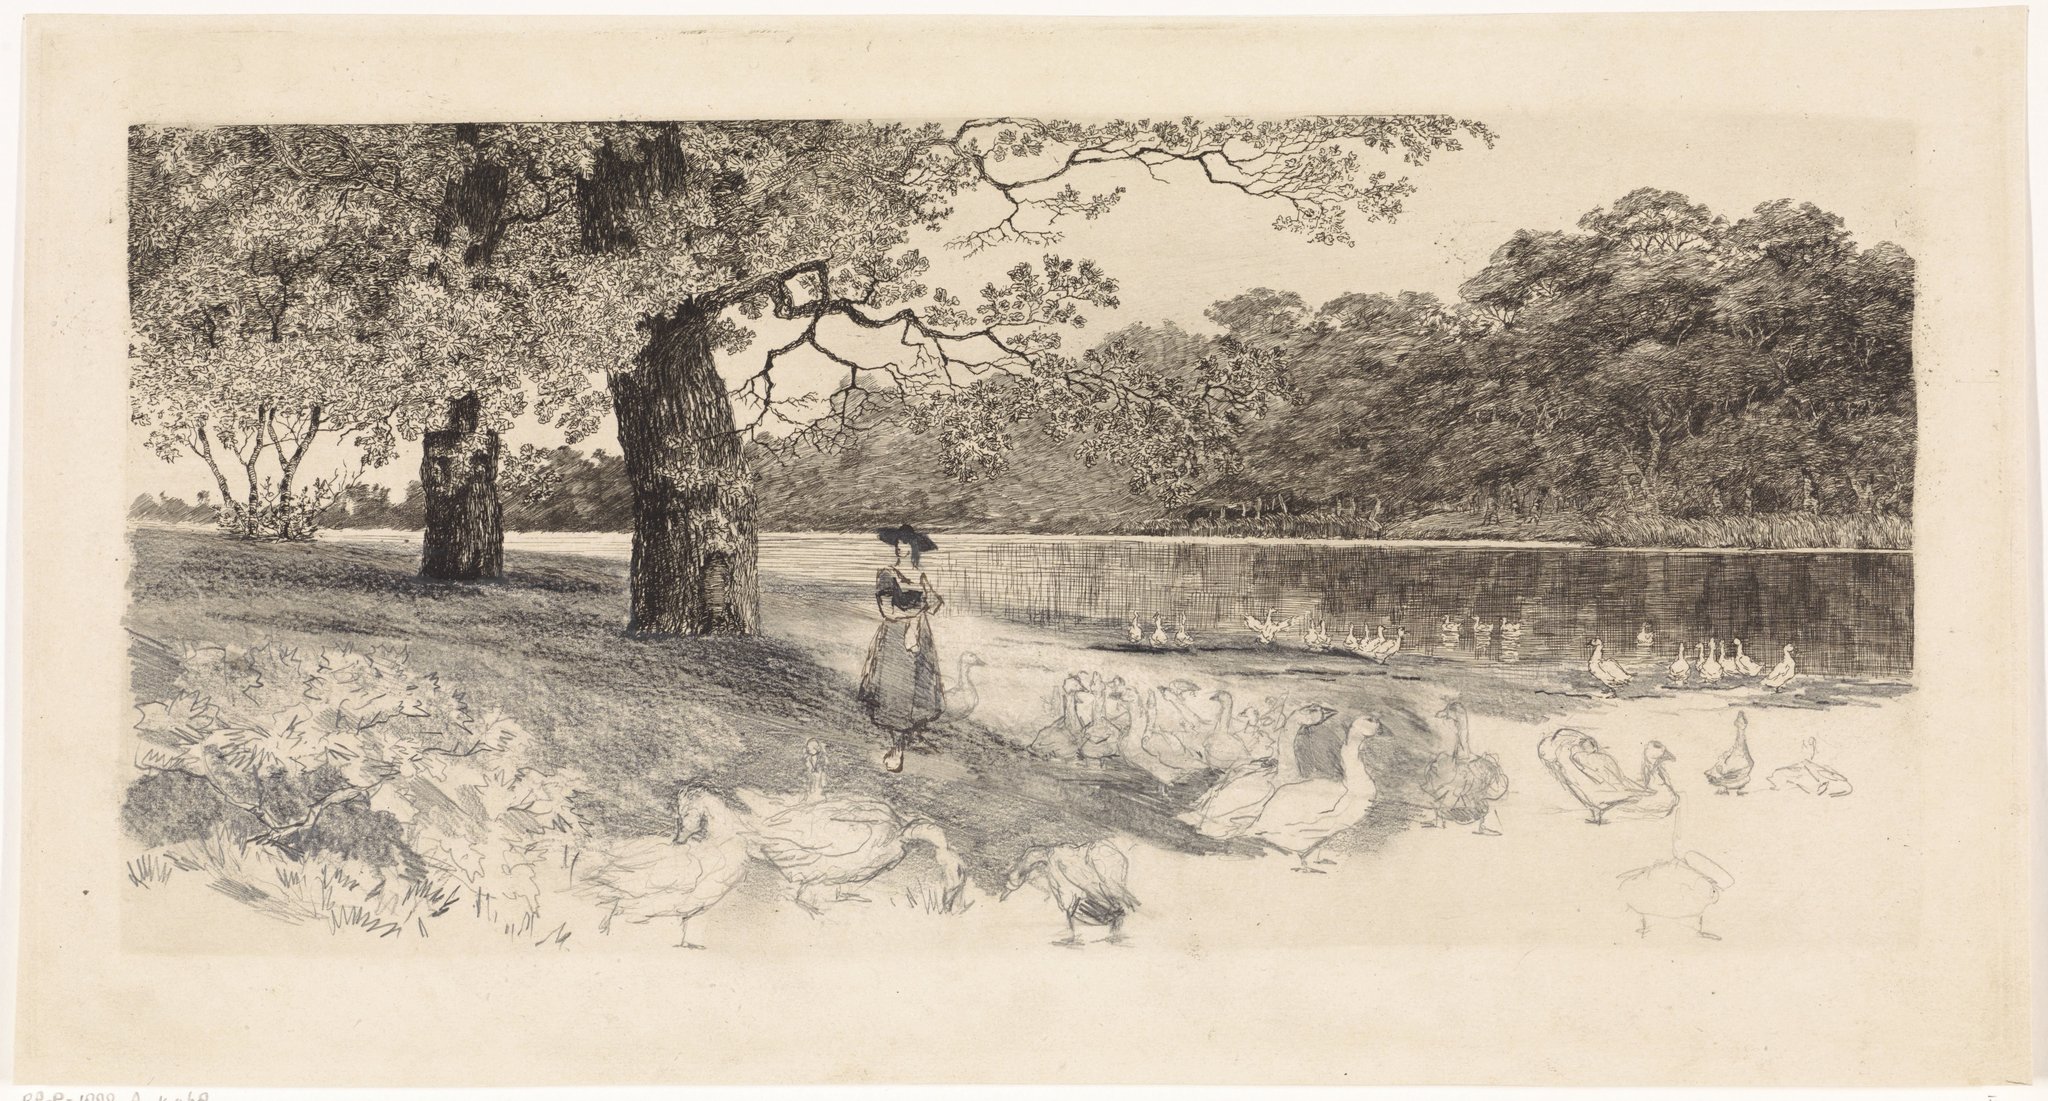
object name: print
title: Ganzen bij het water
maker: elias stark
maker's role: draughtsman, print maker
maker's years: 1849-1933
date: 1887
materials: paper, pencil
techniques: etching, pen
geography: nieuwer-amstel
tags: adolescent, young woman, maiden, trees, water-birds: goose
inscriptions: collector's mark: Lugt 2228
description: Een troep ganzen aan het water. Op de oever staat een jonge vrouw met hoed op het hoofd.